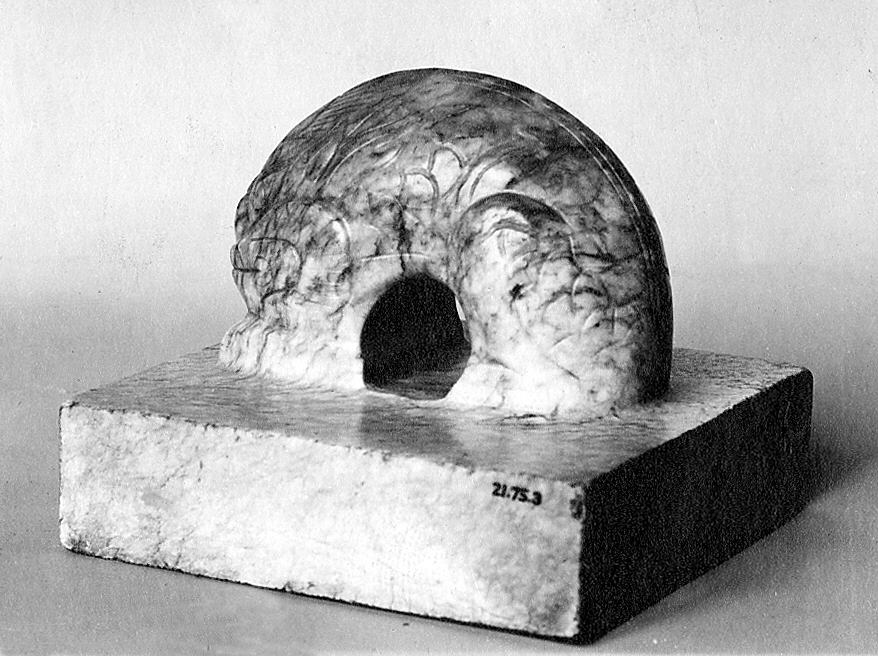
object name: imperial seal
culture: chinese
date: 960-1279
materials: jade